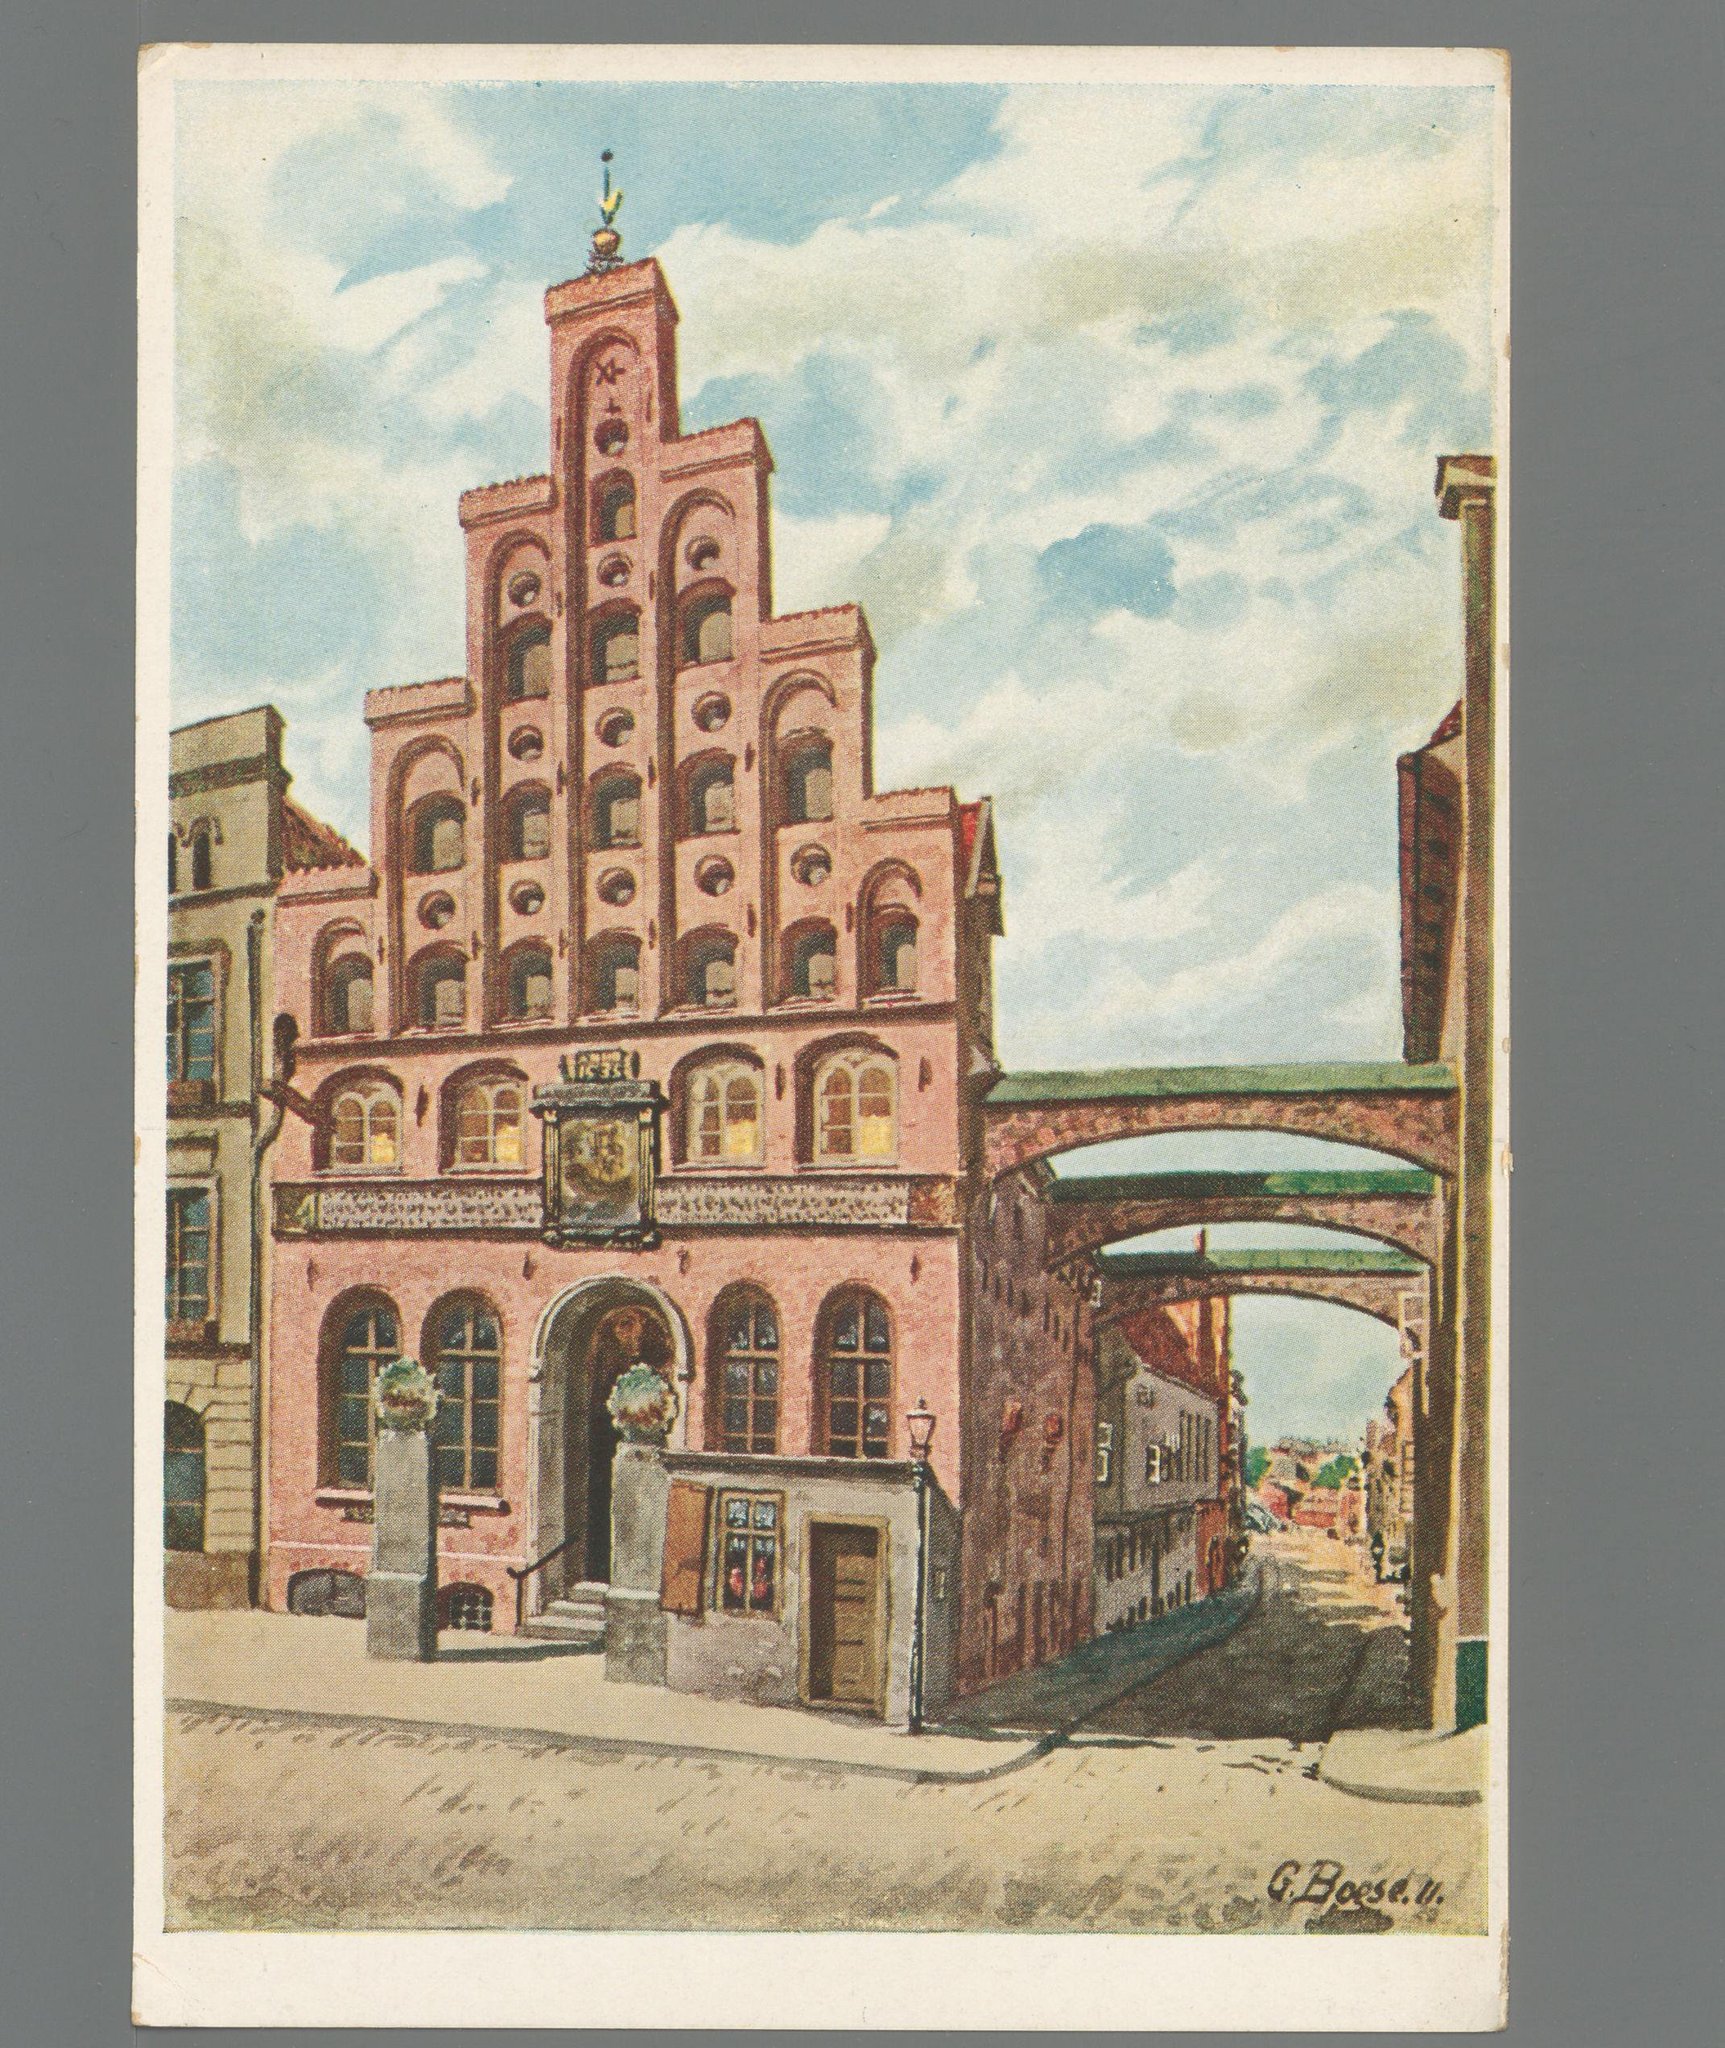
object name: reproduction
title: Lübeck. Haus der Schiffergesellschaft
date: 1911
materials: cardboard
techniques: color autotype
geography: lübeck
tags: street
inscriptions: date